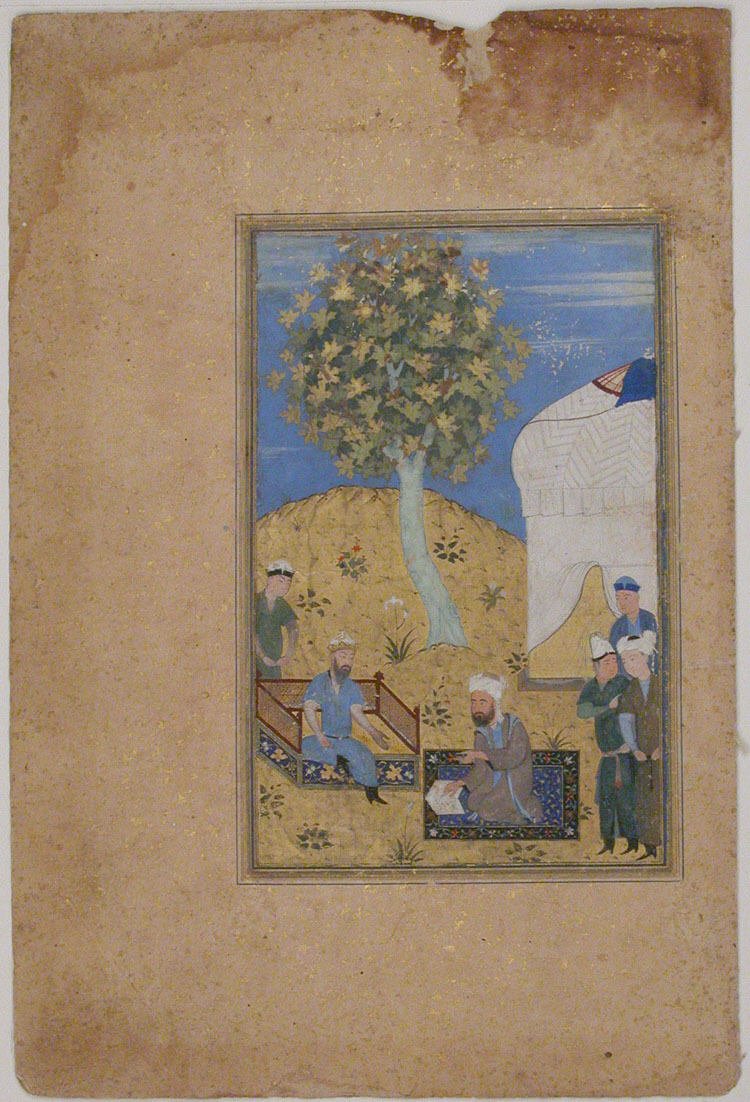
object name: folio from an illustrated manuscript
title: "Sultan Listening to a Man Reading from a Manuscript", Folio from a Manuscript by Mir Ali Shir Nava'i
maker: mir ali shir nava'i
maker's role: author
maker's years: 1416-1526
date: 1501-1533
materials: gold, ink, paper, watercolor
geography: uzbekistan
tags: men,reading,trees